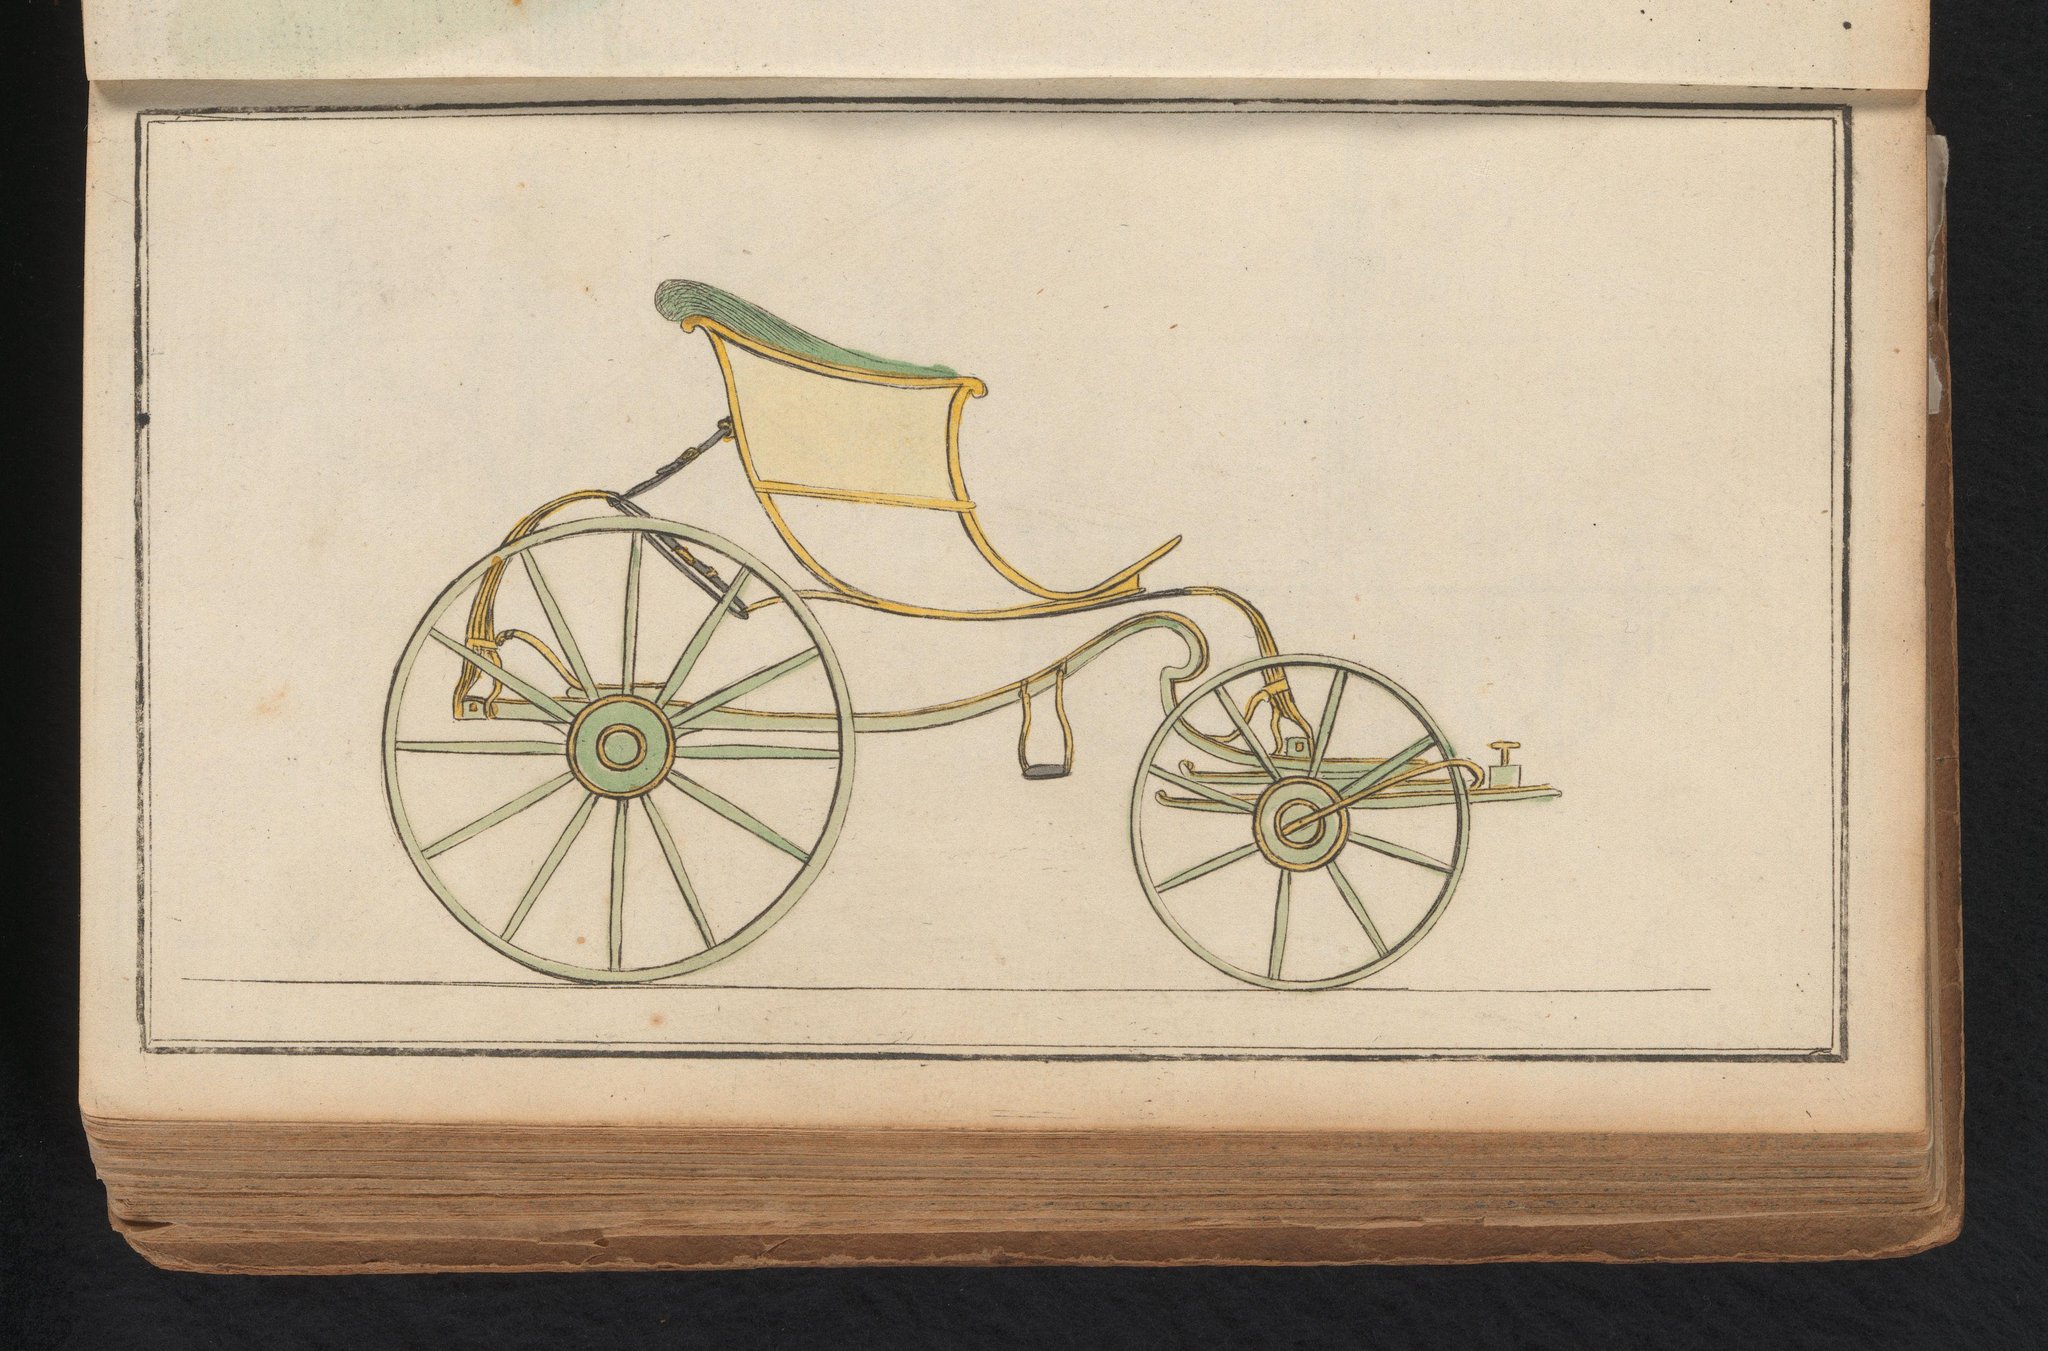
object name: fashion print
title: Journal des Luxus und der Moden 1786, Band I, T. 21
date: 1786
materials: paper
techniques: etching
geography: weimar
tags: fashion plates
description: Een nieuw model 'Engelse Wisky". Prent uit het modetijdschrift Journal des Luxus und der Moden, uitgegeven door Friedrich Justin Bertuch en Georg Melchior Kraus, Weimar, 1786-1826.